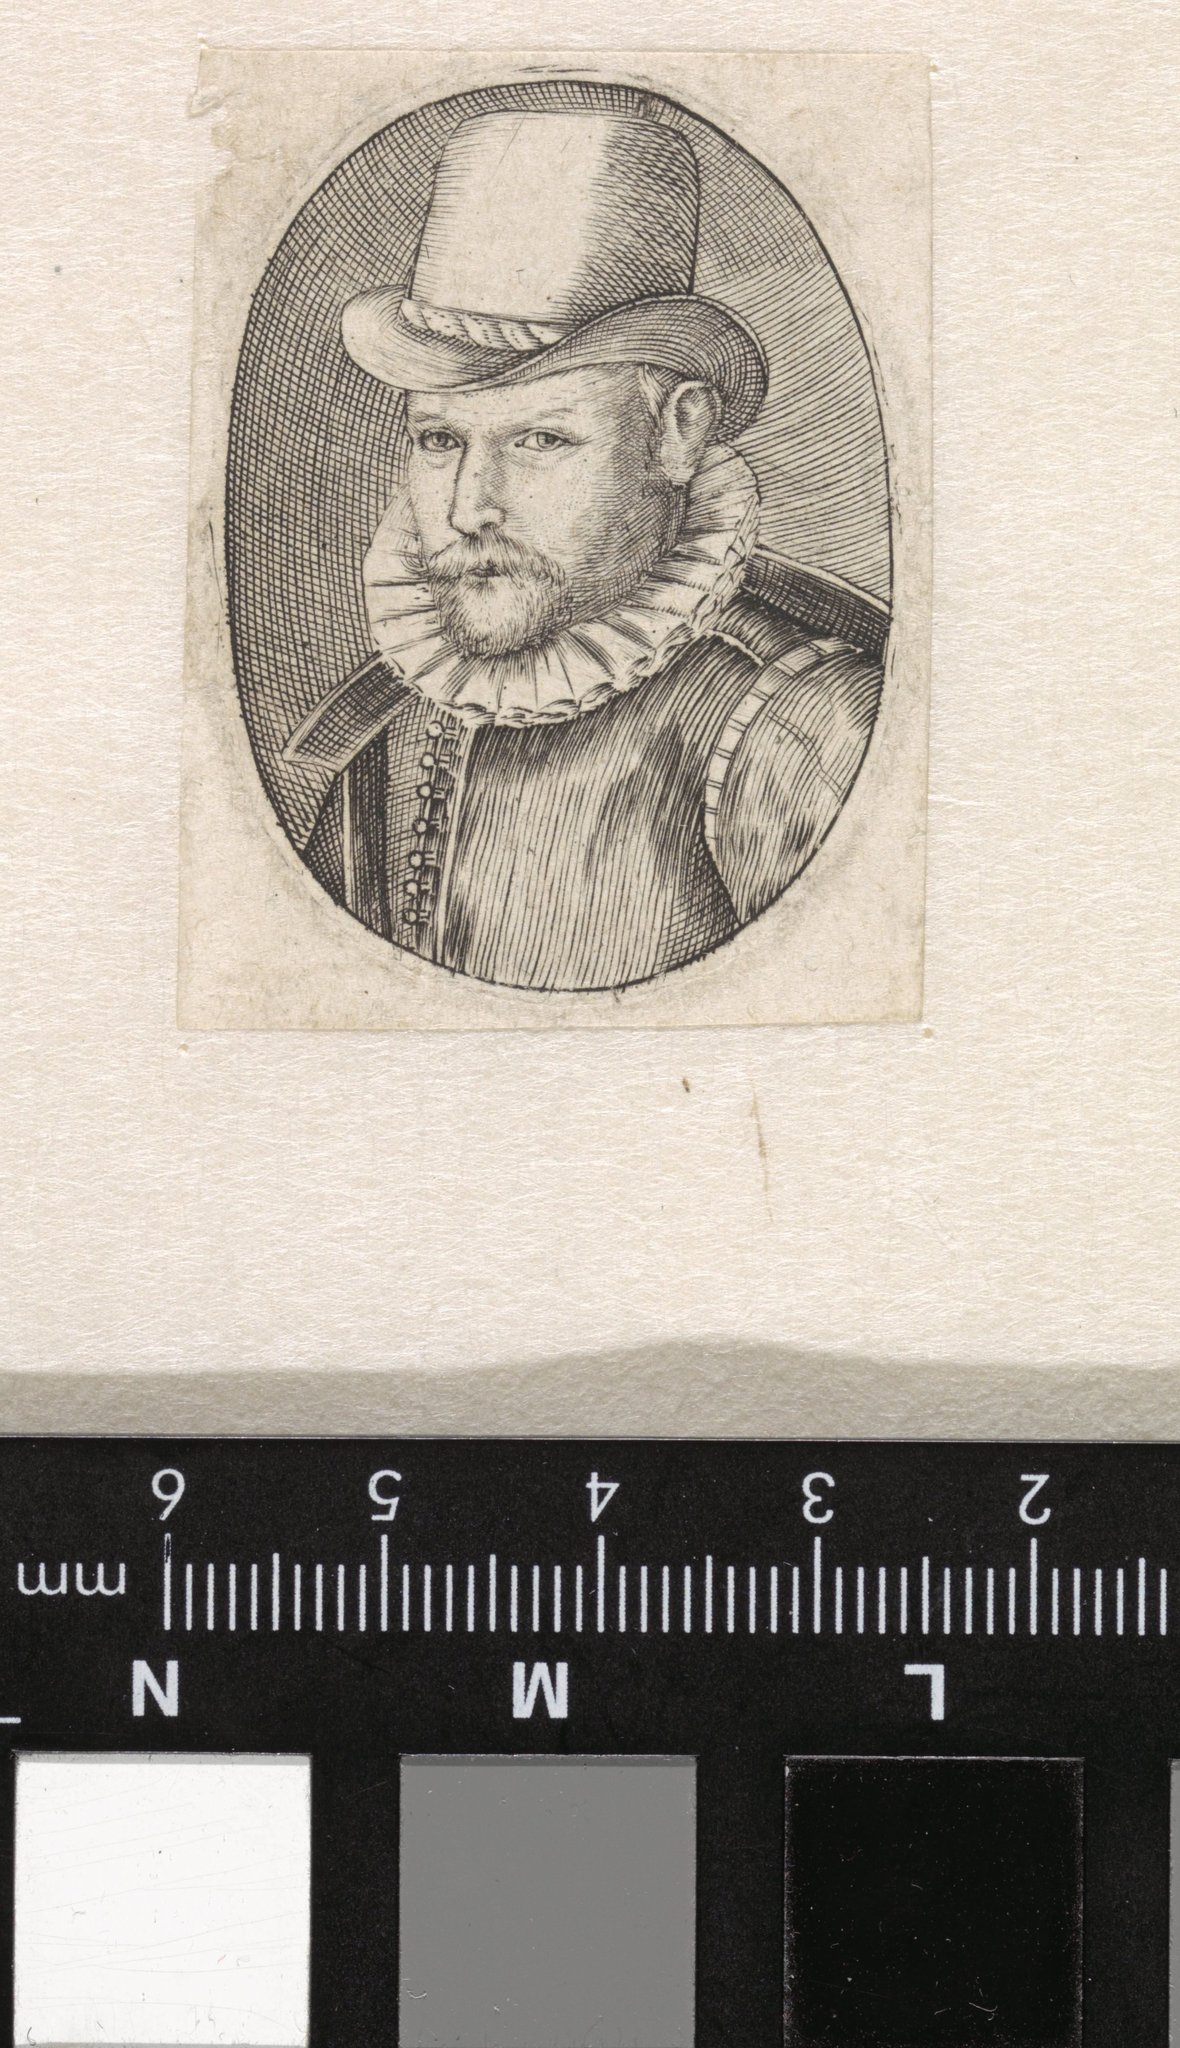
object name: print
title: Portret van een man met hoed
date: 1579-1665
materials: paper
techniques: engraving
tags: head-gear: hat (+ men's clothes)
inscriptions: collector's mark: Lugt 2228